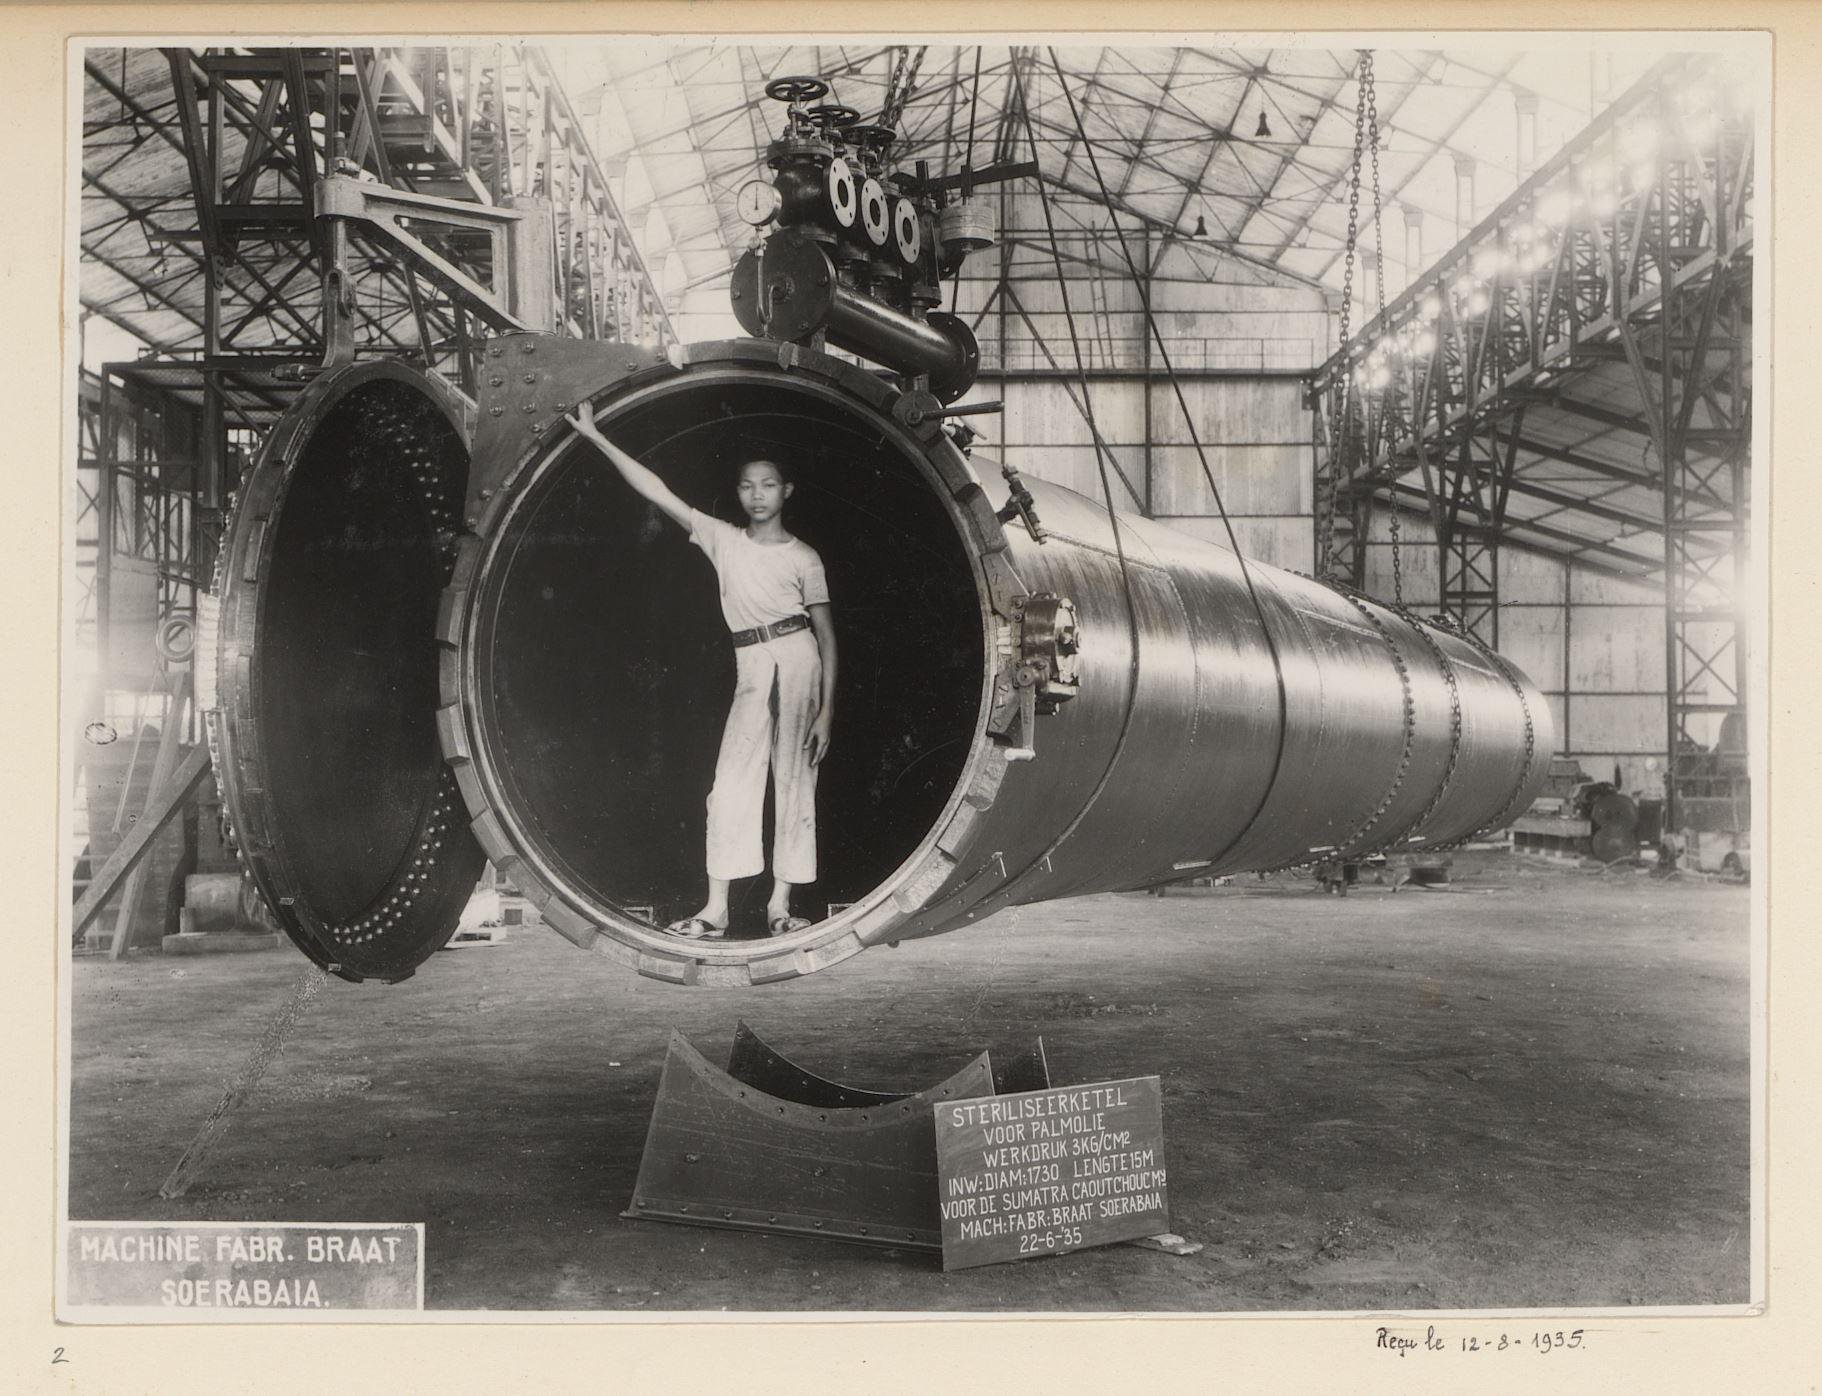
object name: photograph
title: Steriliseerketel voor palmolie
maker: Anonymous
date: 1935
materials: photographic support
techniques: gelatin silver print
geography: surabaya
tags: asiatic races and peoples (indonesians), parts of machines, (non-fruit) products of plants or trees: palm oil, surabaya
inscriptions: date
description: Een steriliseerketel voor de fabricage van palmolie bestemd voor de onderneming Sucama, vervaardigd in de machinefabriek Braat te Soerabaja. Een jongen poseert staande in de ketel. Onderdeel van het fotoalbum over de plantages Brussel en Pernantian van de Sumatra Caoutchouc Maatschappij op de Oostkust van Sumatra in de jaren 1910-1935.